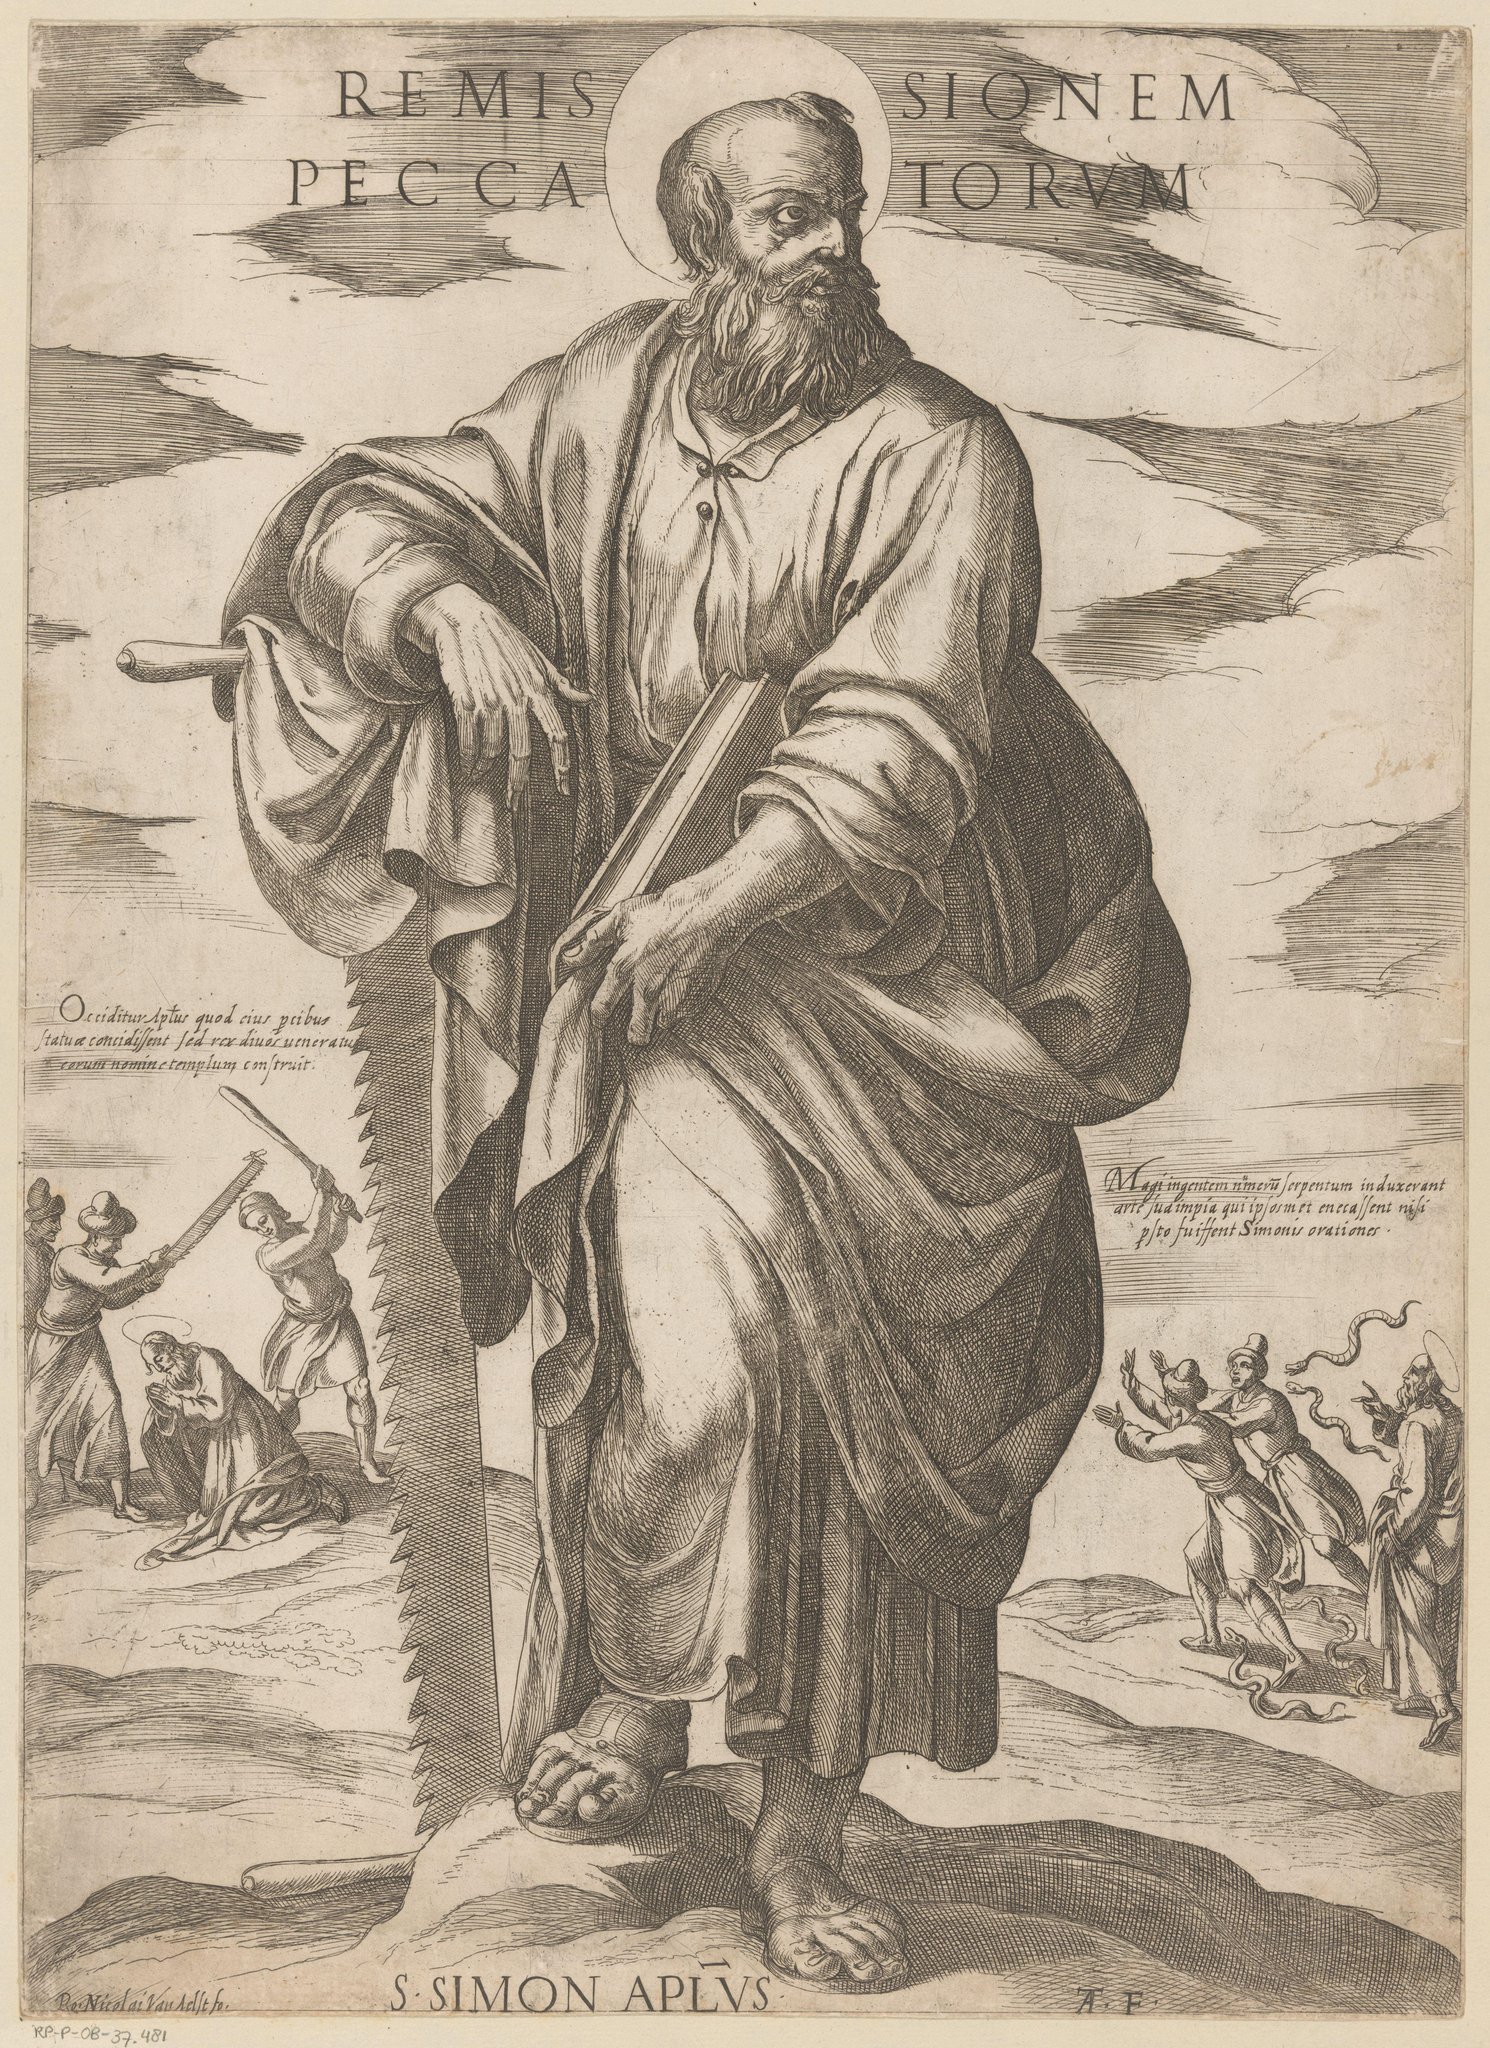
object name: print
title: Remissionem peccatorum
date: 1565-1630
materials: paper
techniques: etching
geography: italy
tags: life and acts of simon zelotes, the apostle simon zelotes (or simon the canaanite); possible attributes: book, saw, scroll, martyrdom and death of simon zelotes: he is sawn in two, or beaten to death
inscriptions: collector's mark: Lugt 240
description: De heilige Simon met zaag en boek. Op de achtergrond links wordt Simon doormidden gezaagd en geslagen met een stok. Op de achtergrond rechts stuurt Simon slangen achter zijn vervolgers aan.